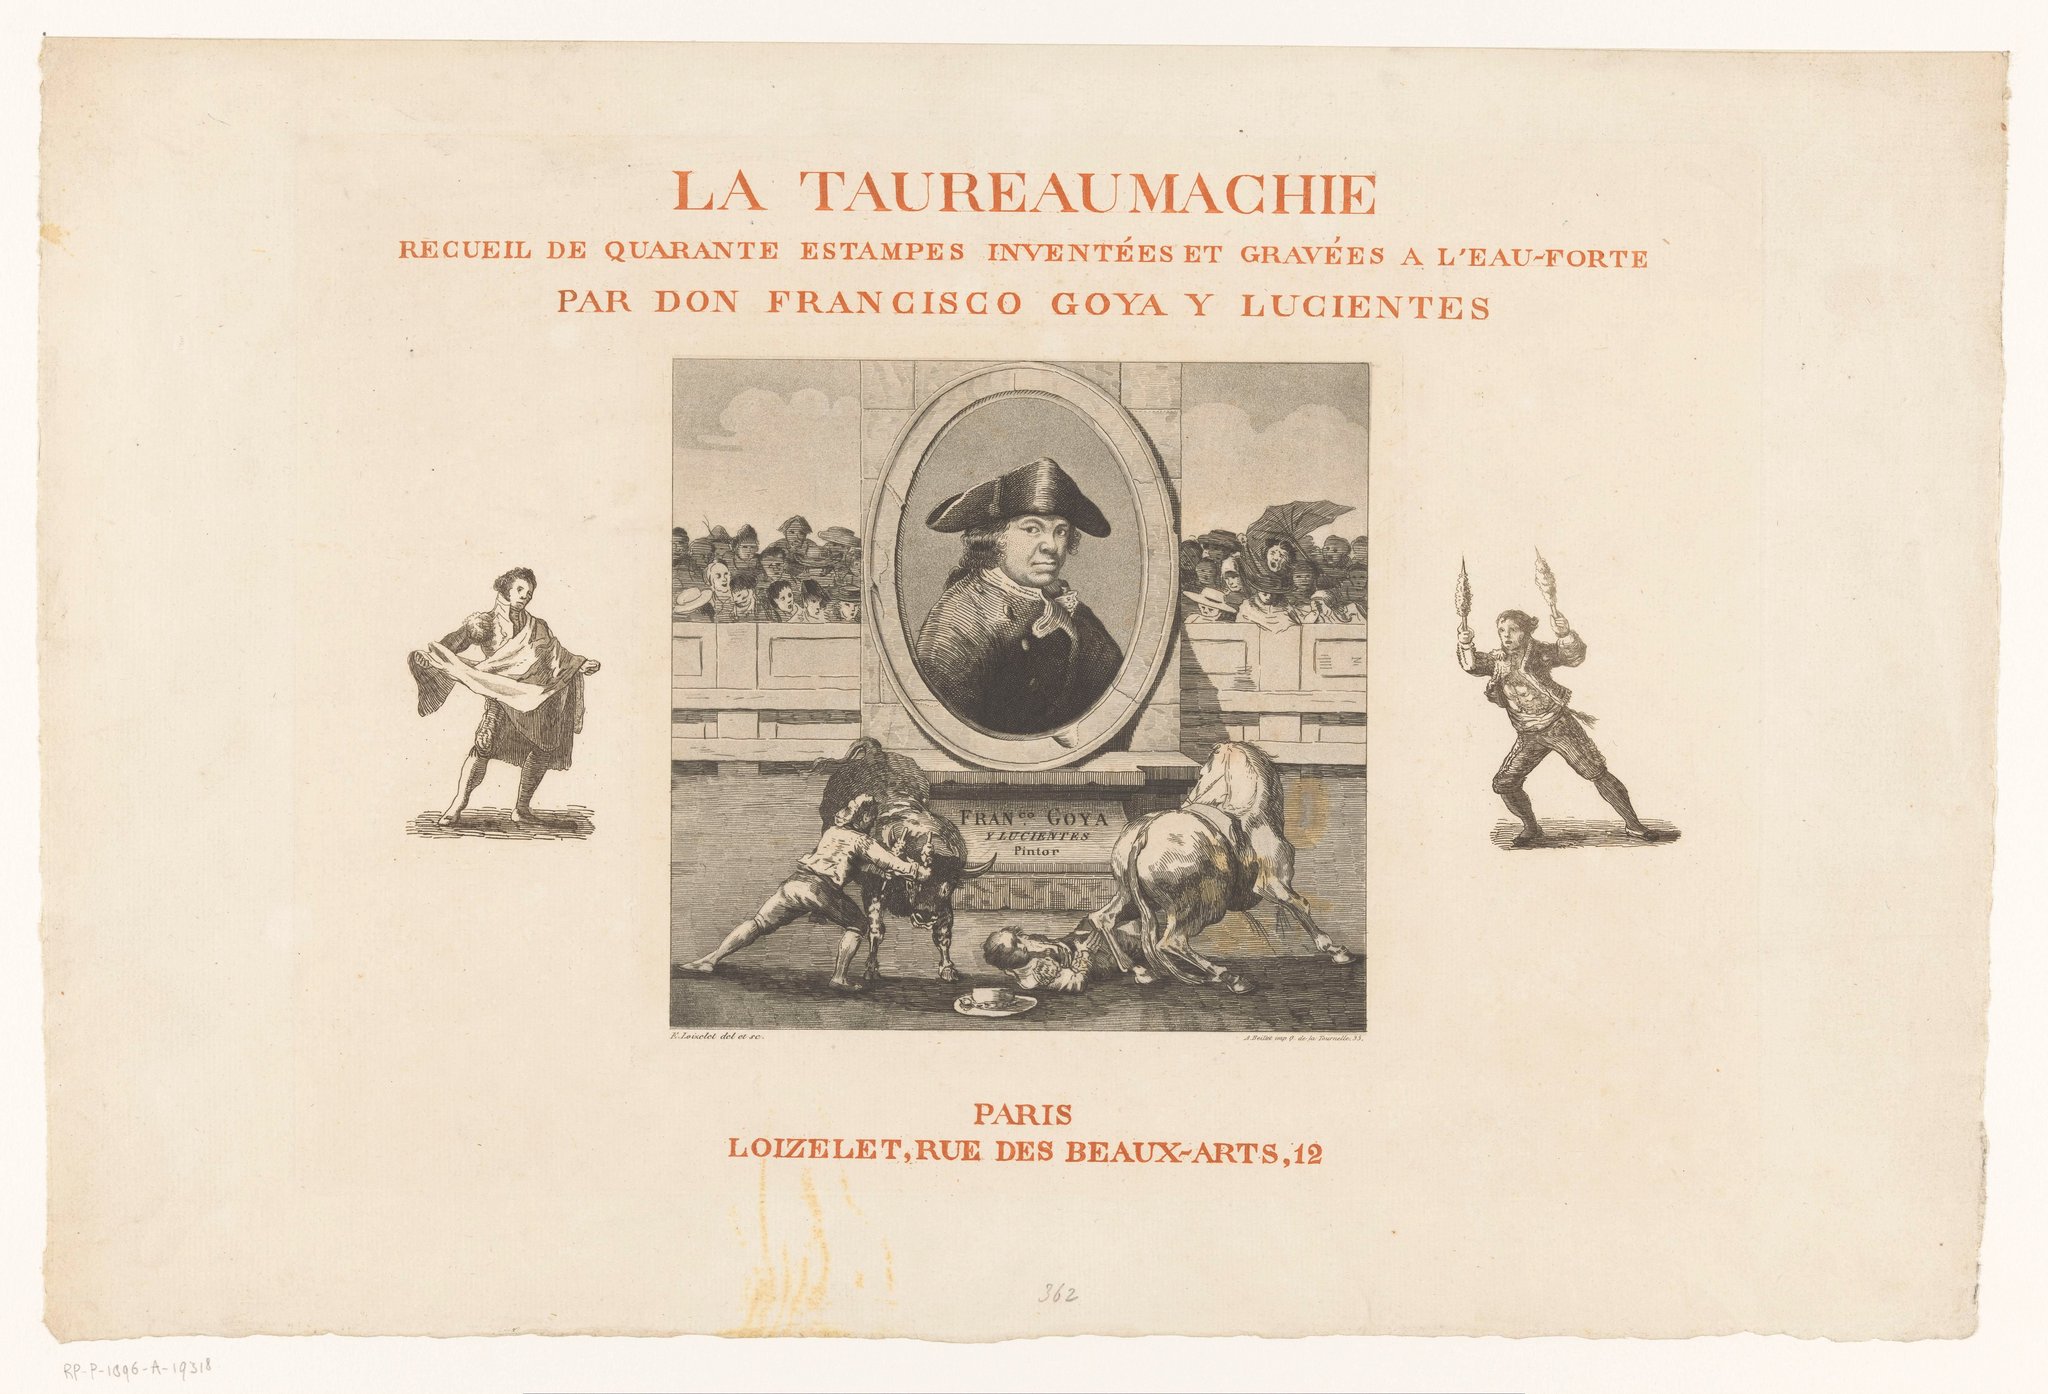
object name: titelprent, frontispice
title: La Taureaumachie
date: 1876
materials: paper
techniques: aquatint, etching, letterpress printing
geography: paris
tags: painter, print maker, draughtsman, francisco de goya, bullfight, portrait, self-portrait of artist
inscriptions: collector's mark: Lugt 2228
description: Titelprent van een serie die behalve de titelprent bestaat uit 40 prenten door Francisco de Goya met voorstellingen van stierengevechten. De eerste editie bestond uit 33 prenten en werd uitgegeven in 1816. Deze reeks betreft de derde editie, uitgegeven in 1876 door Eugène Loizelet en door hem voorzien van een titelprent en lijst met titels. Naast de 33 prenten publiceerde Loizelet ook de prenten die door Goya op de achterkanten van 7 van de platen werden geëtst.